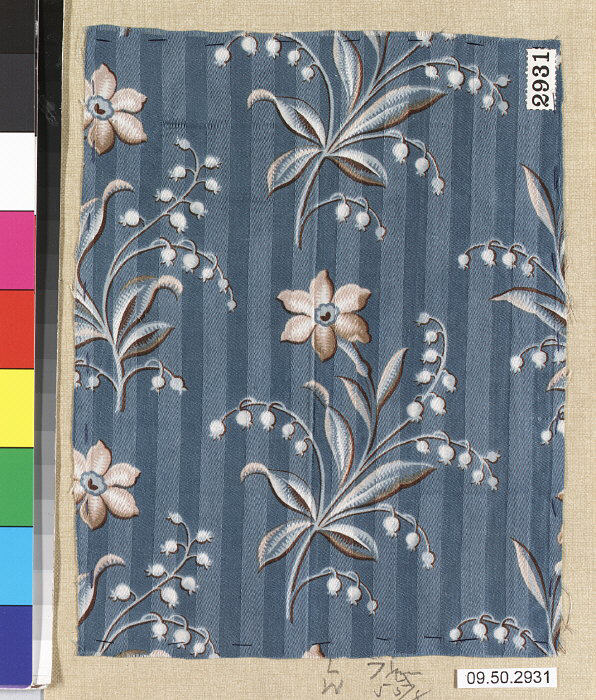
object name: piece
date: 1801-1900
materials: cotton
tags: flowers,leaves